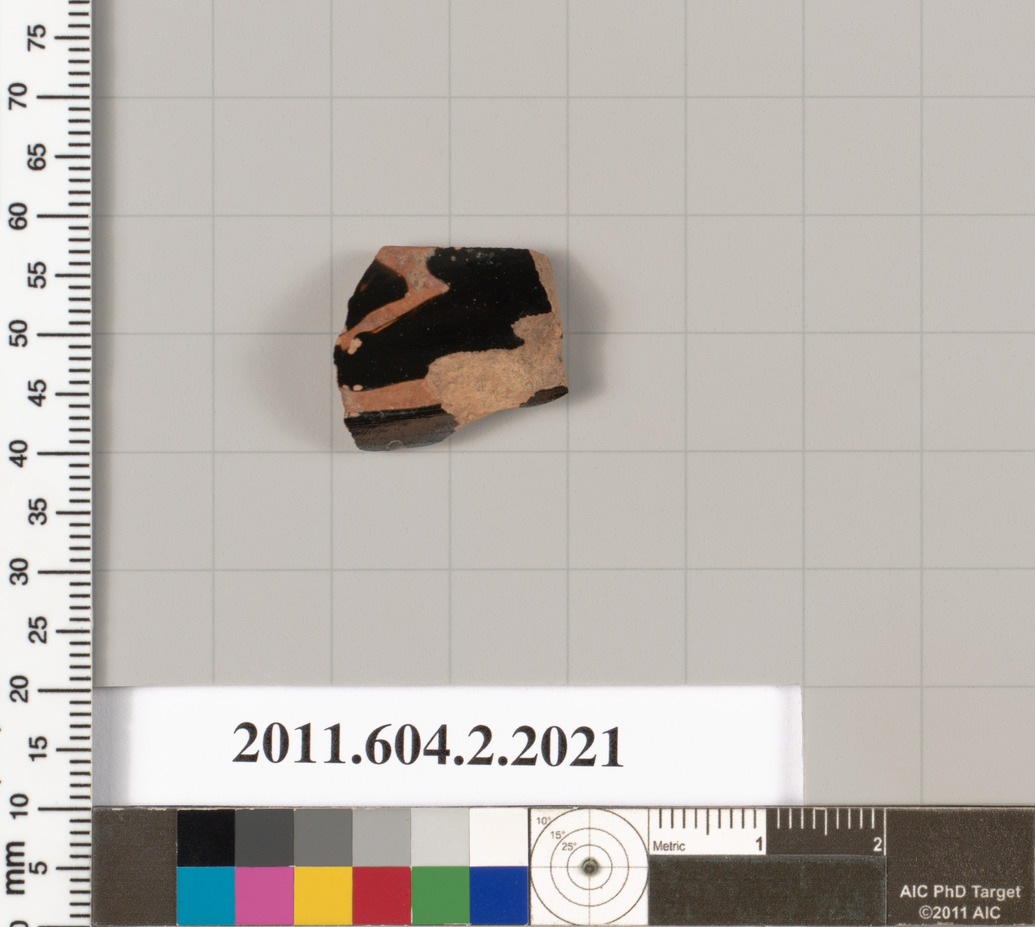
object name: askos fragment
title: Terracotta fragment of an askos (flask with a spout and handle over the top)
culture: greek, attic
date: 420-400 BCE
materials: terracotta